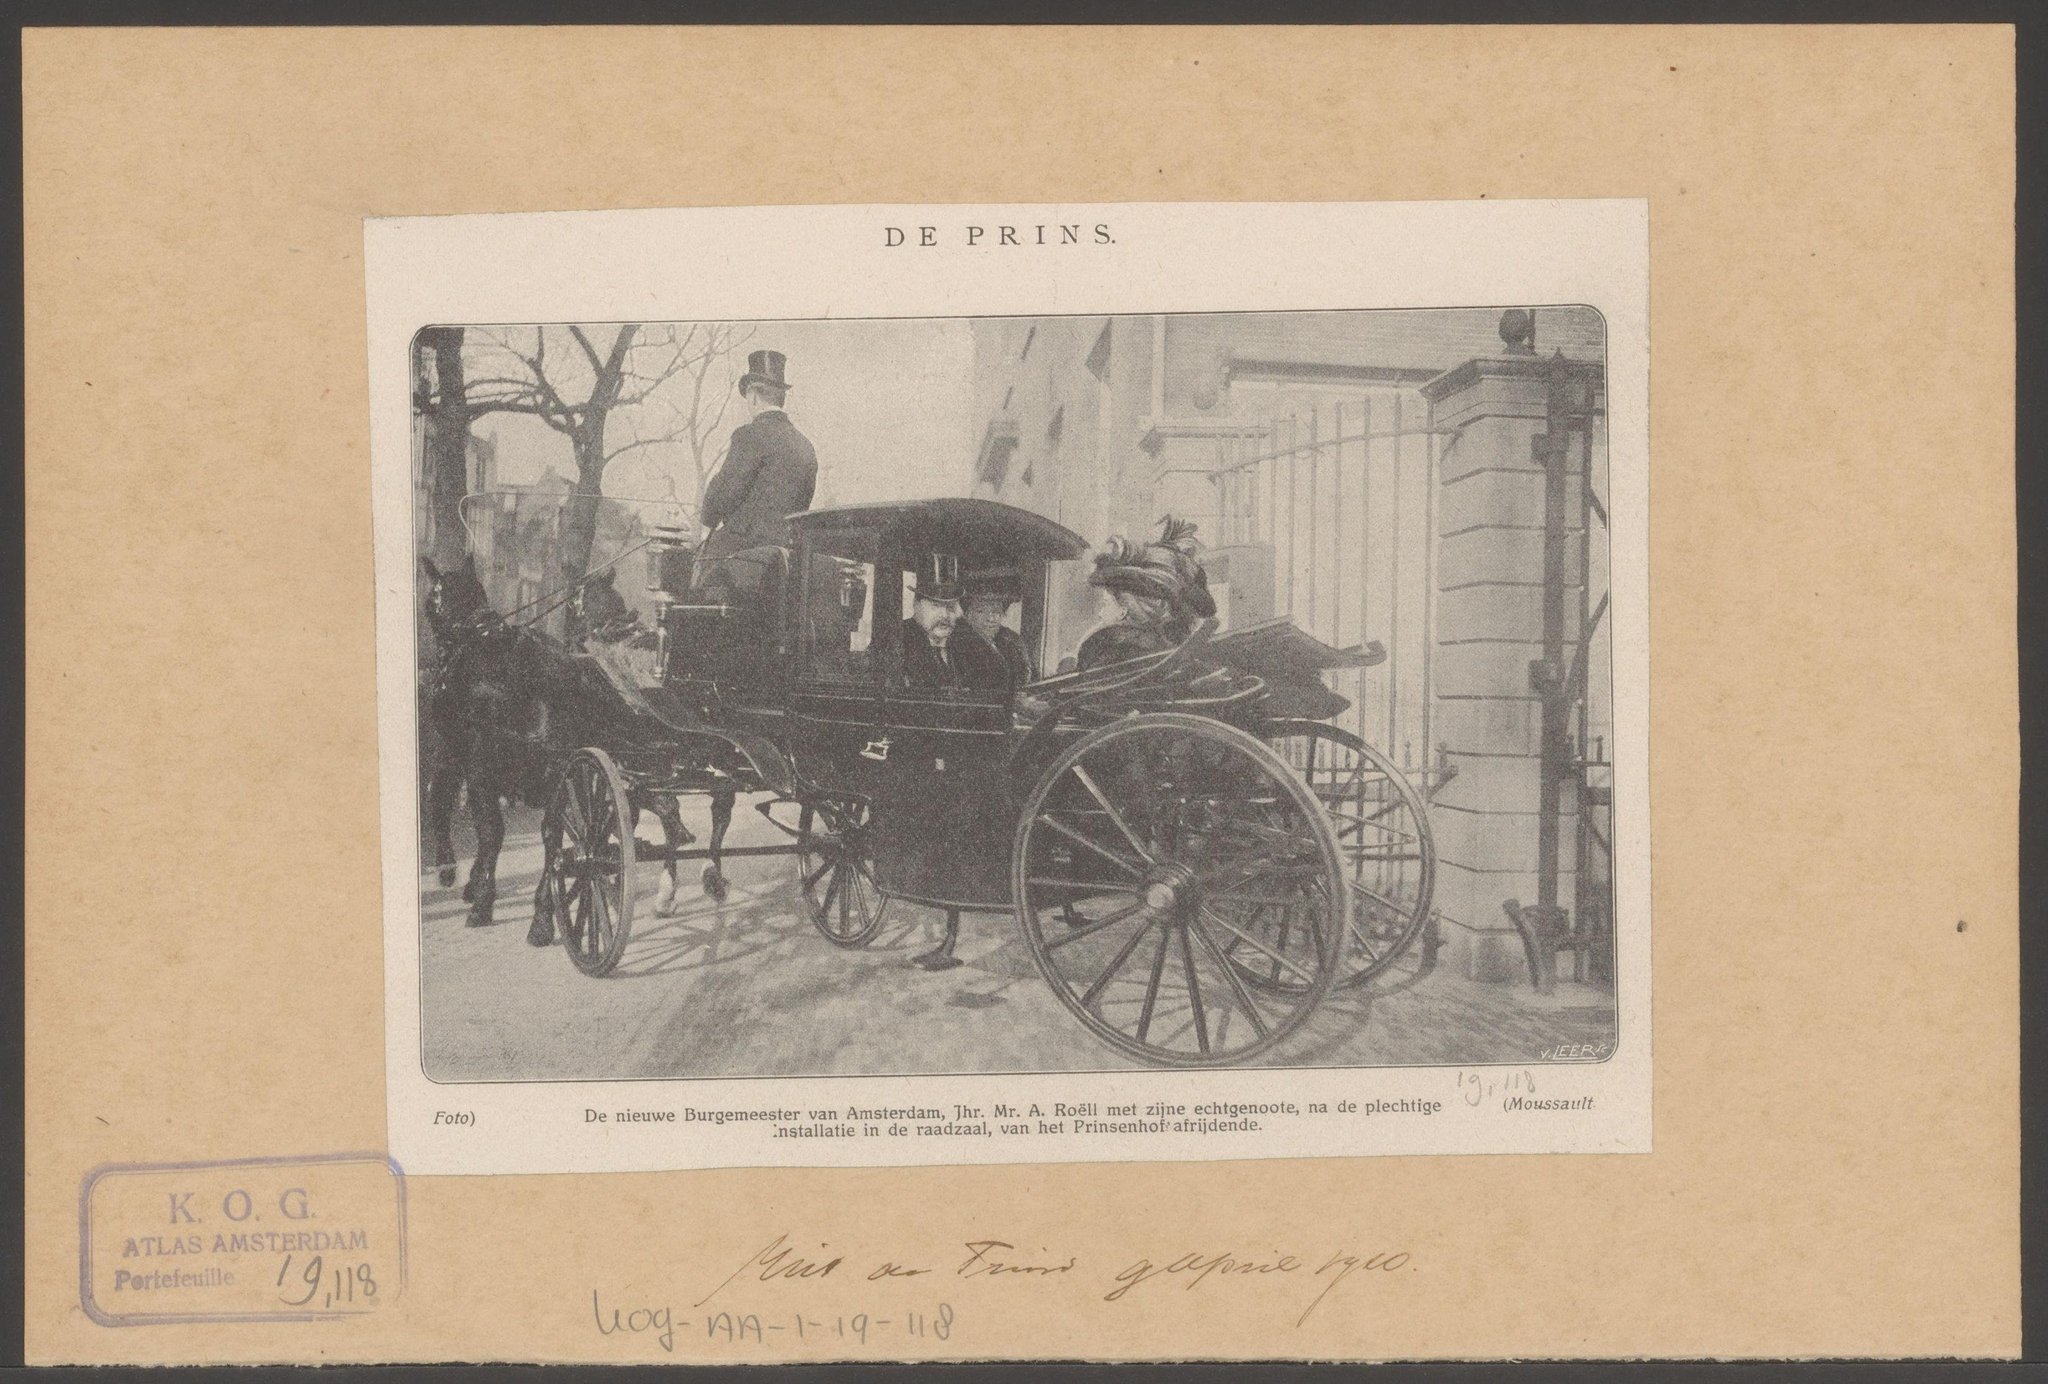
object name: photomechanical print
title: Koets met burgemeester Antonie Röell en diens echtgenote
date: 1910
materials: paper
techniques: letterpress printing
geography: amsterdam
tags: the hague, antonie röell, mayor, burgomaster, four-wheeled vehicle drawn by two animals, amsterdam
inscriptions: collector's mark: ‘19,118’ Lugt 1641b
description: Onderwerpsrubriek binnen de Atlas Amsterdam: Herinneringen aan regeringsleden en hunne huisgezinnen [na 1800].